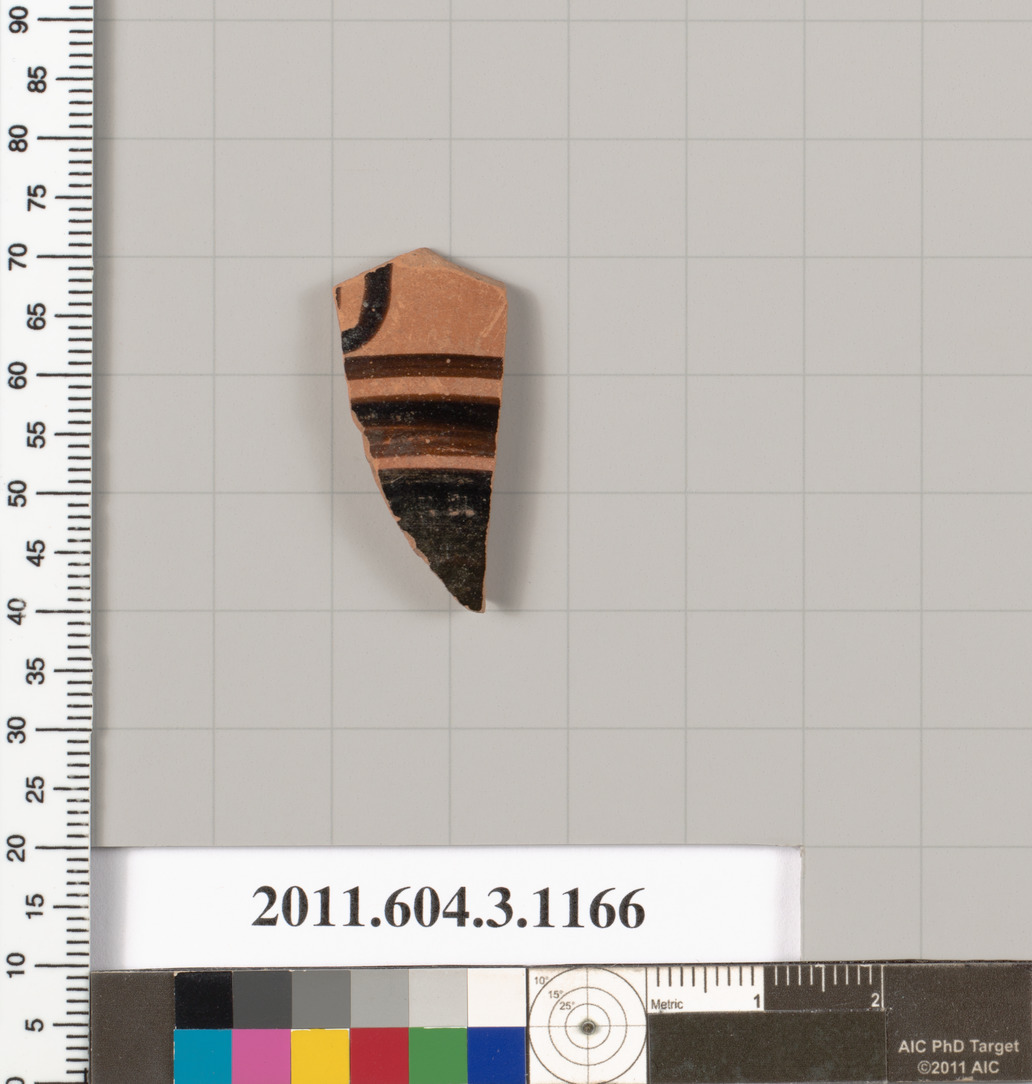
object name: mastoid or kyathos fragment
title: Terracotta fragment of a mastoid (drinking cup with narrow base) or a kyathos (cup-shaped ladle)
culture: greek, attic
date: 534-468 BCE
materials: terracotta